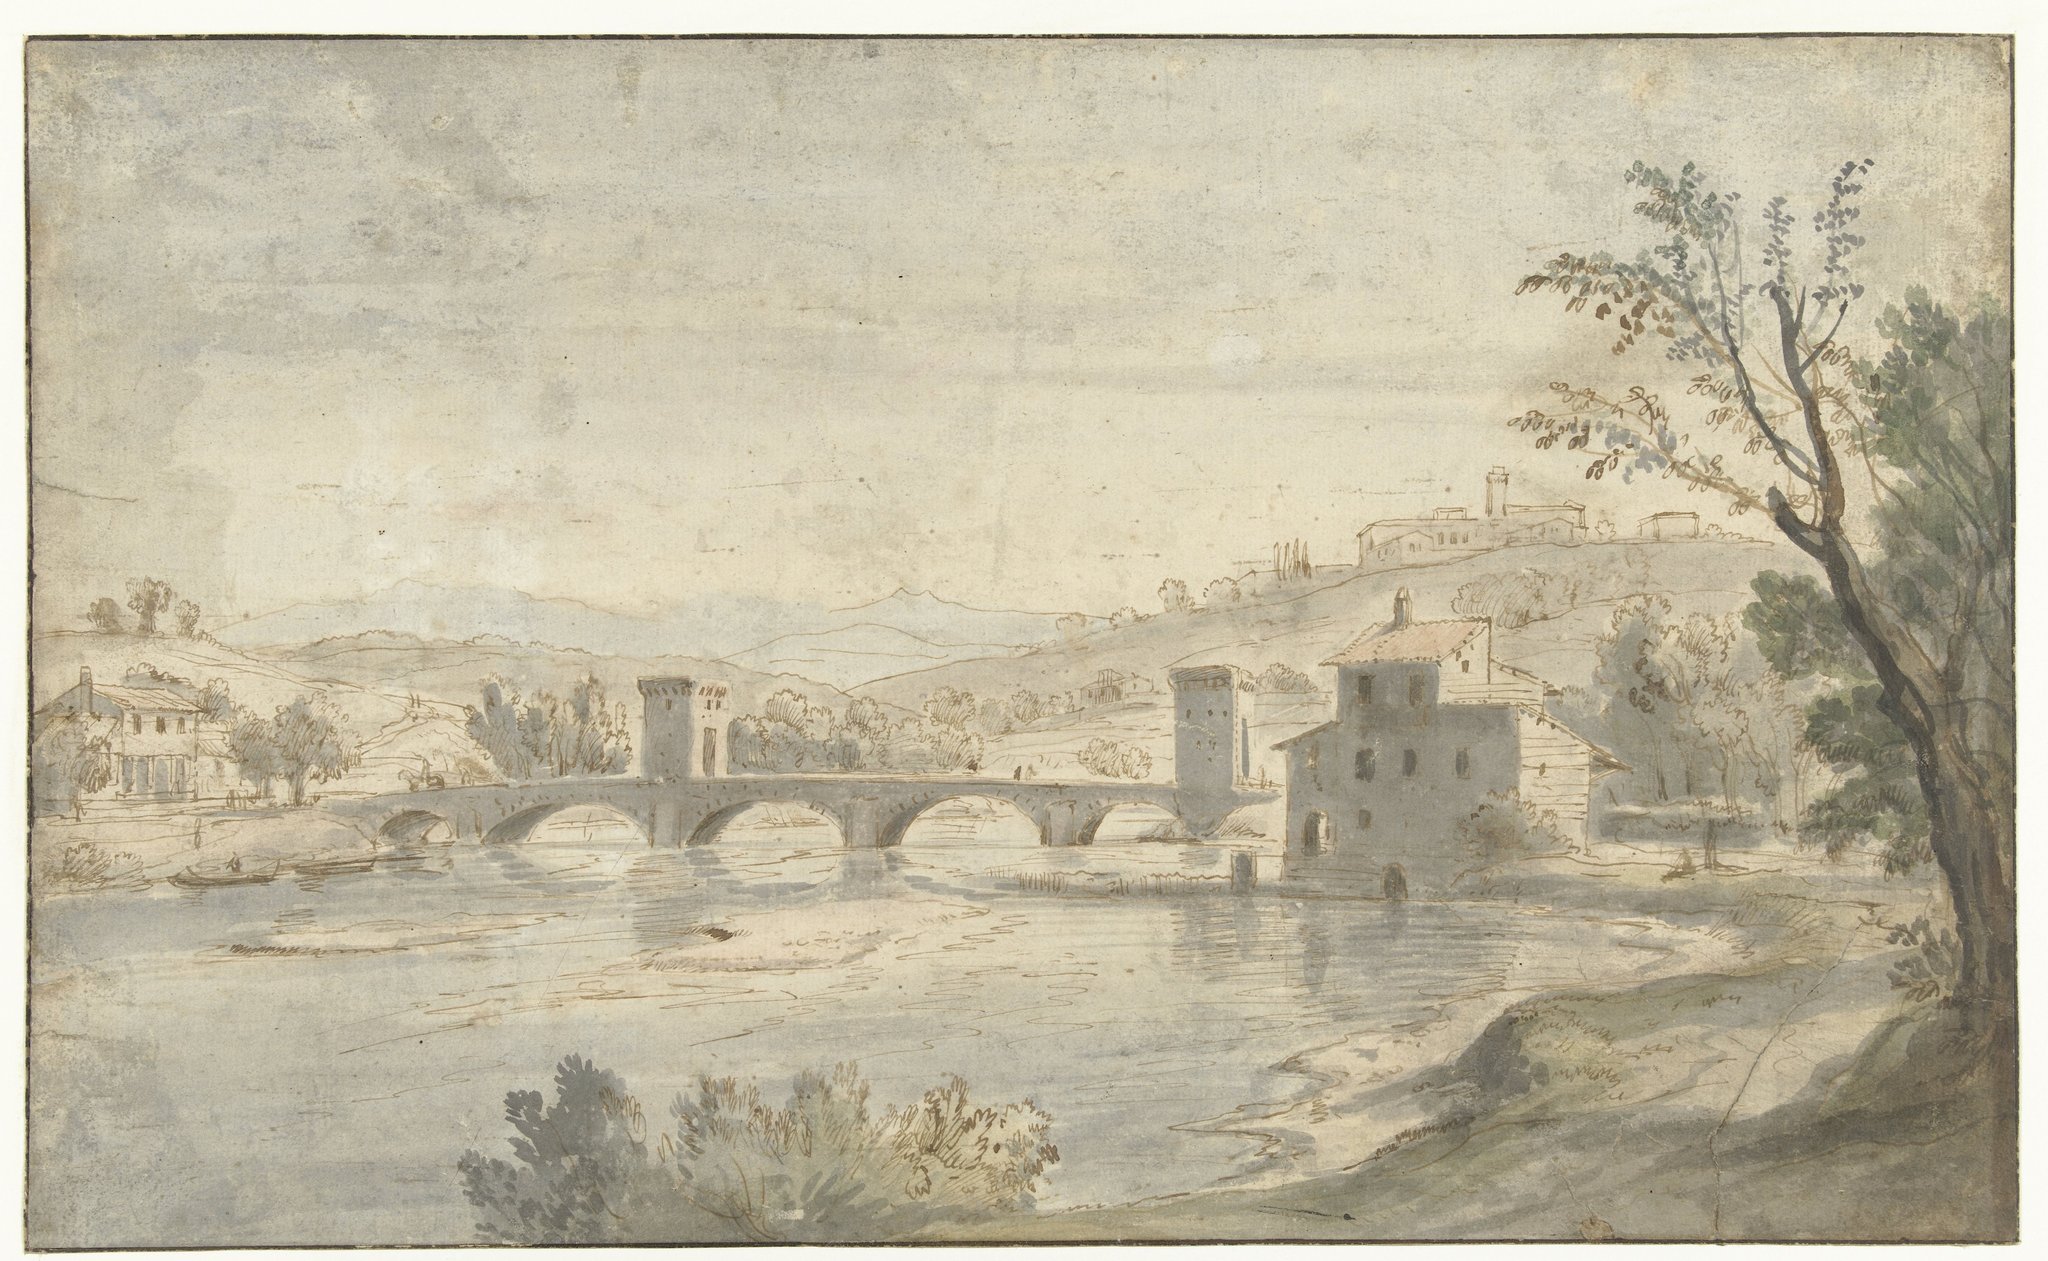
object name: drawing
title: Italianate River Landscape with a Bridge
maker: caspar van wittel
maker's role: draughtsman, painter, print maker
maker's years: 1652-1736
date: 1674-1736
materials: ink, paper, watercolor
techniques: brush, pen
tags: river, landscape with bridge, viaduct or aqueduct